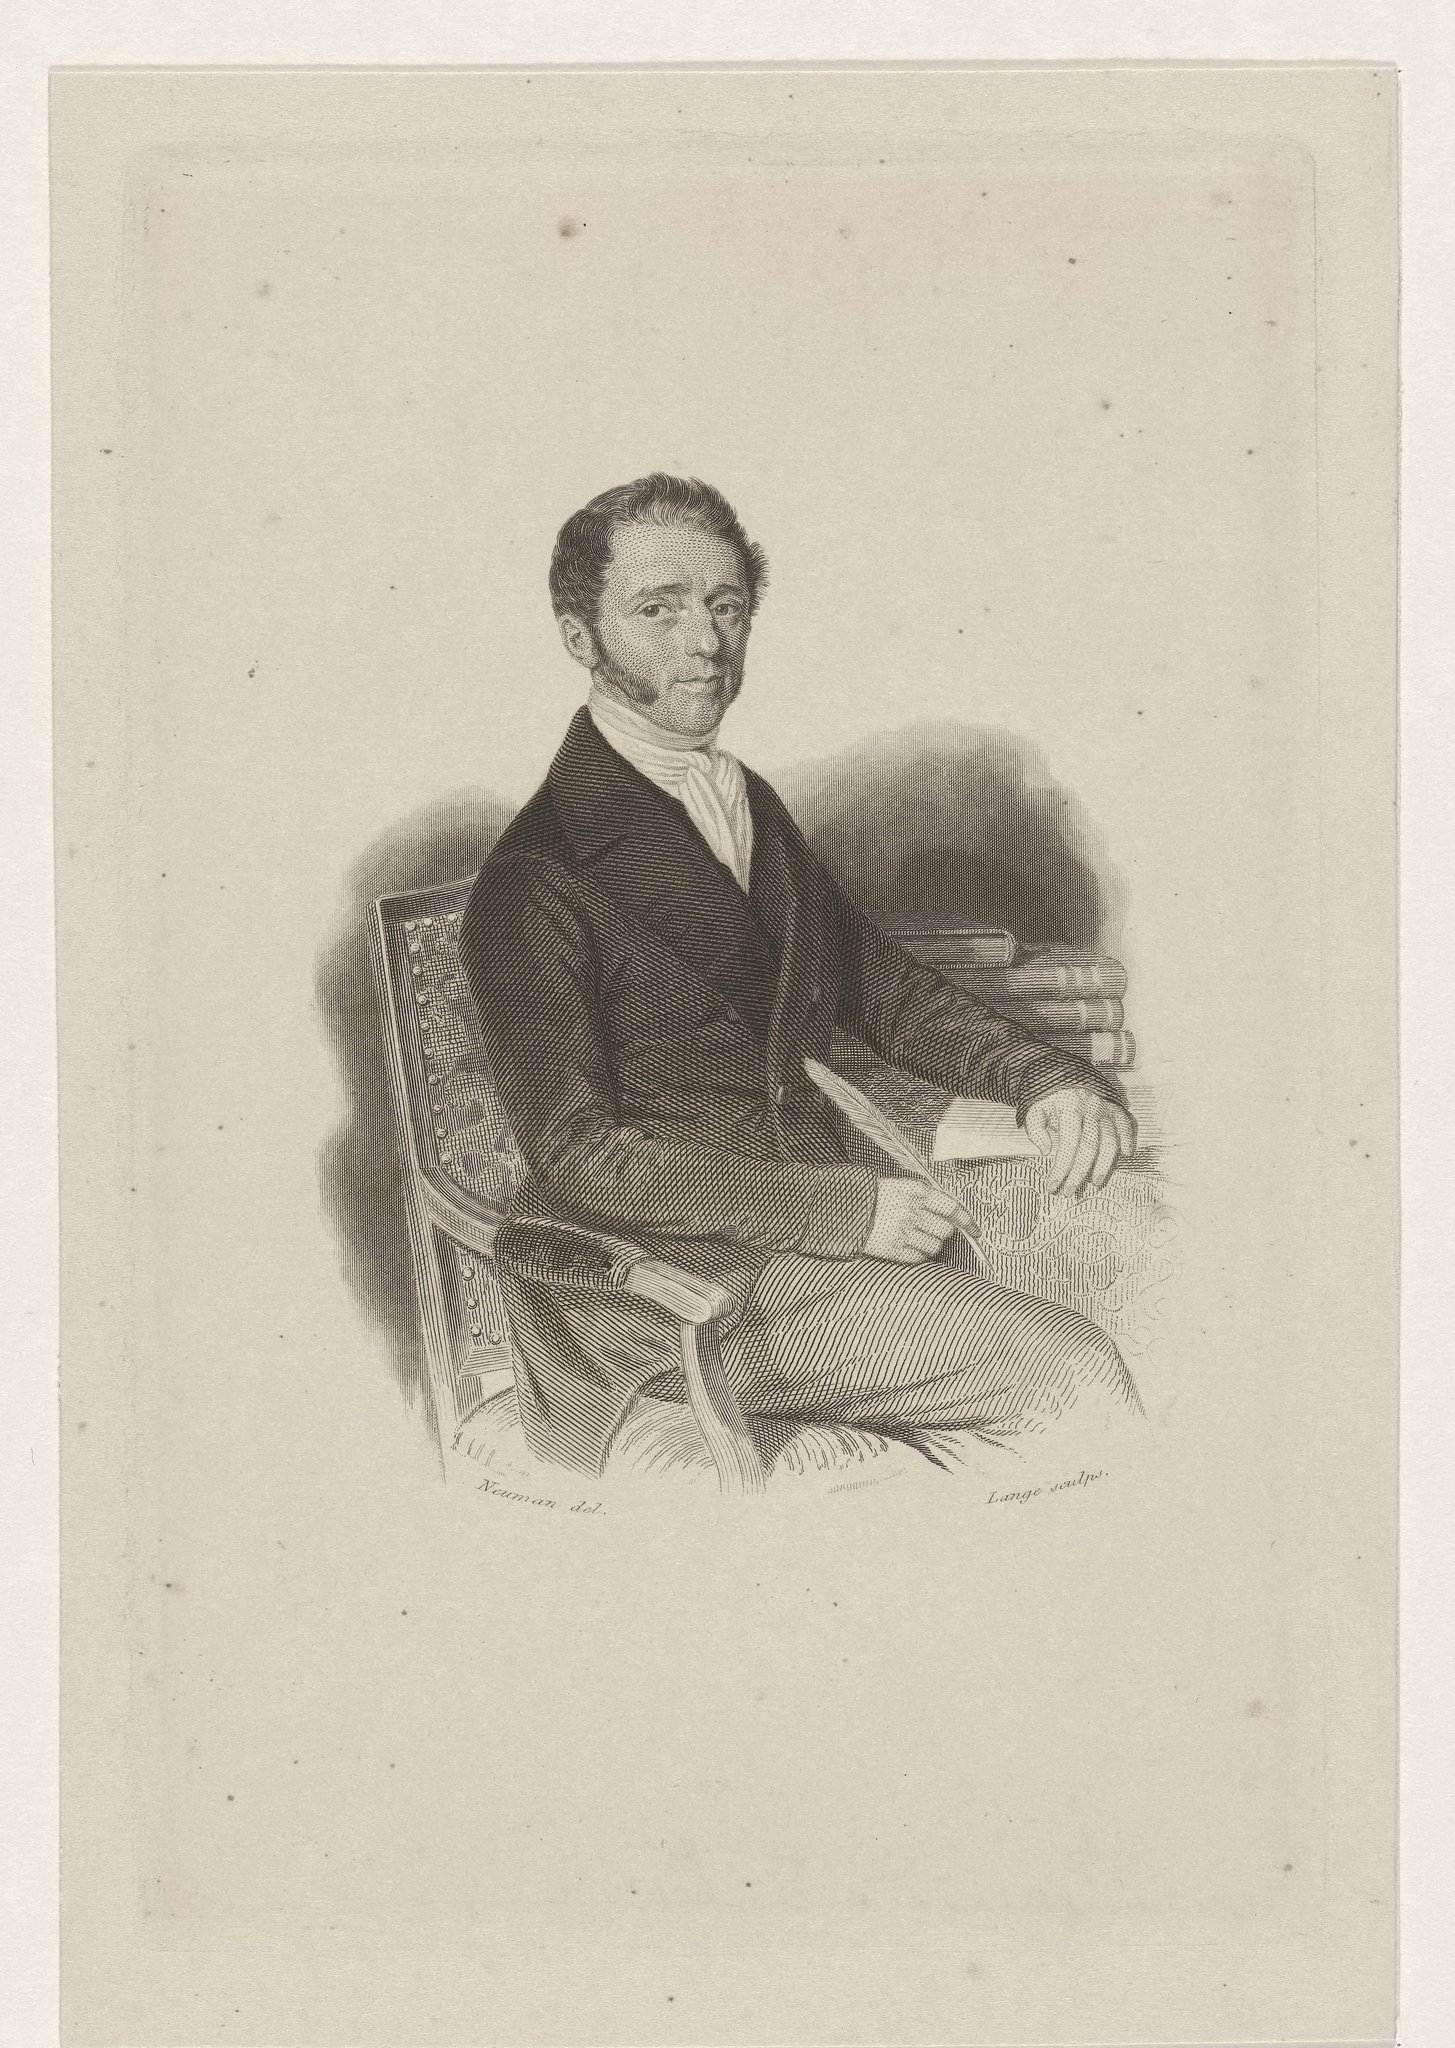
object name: print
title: Portret van Cornelis Elisa van Koetsveld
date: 1820-1849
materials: paper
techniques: engraving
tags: the hague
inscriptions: collector's mark: Lugt 2228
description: Cornelis Elisa van Koetsveld, hervormd predikant te Schoonhoven en Den Haag. Kniestuk, zittend in een stoel naar rechts gedraaid met een schrijfveer in de hand.